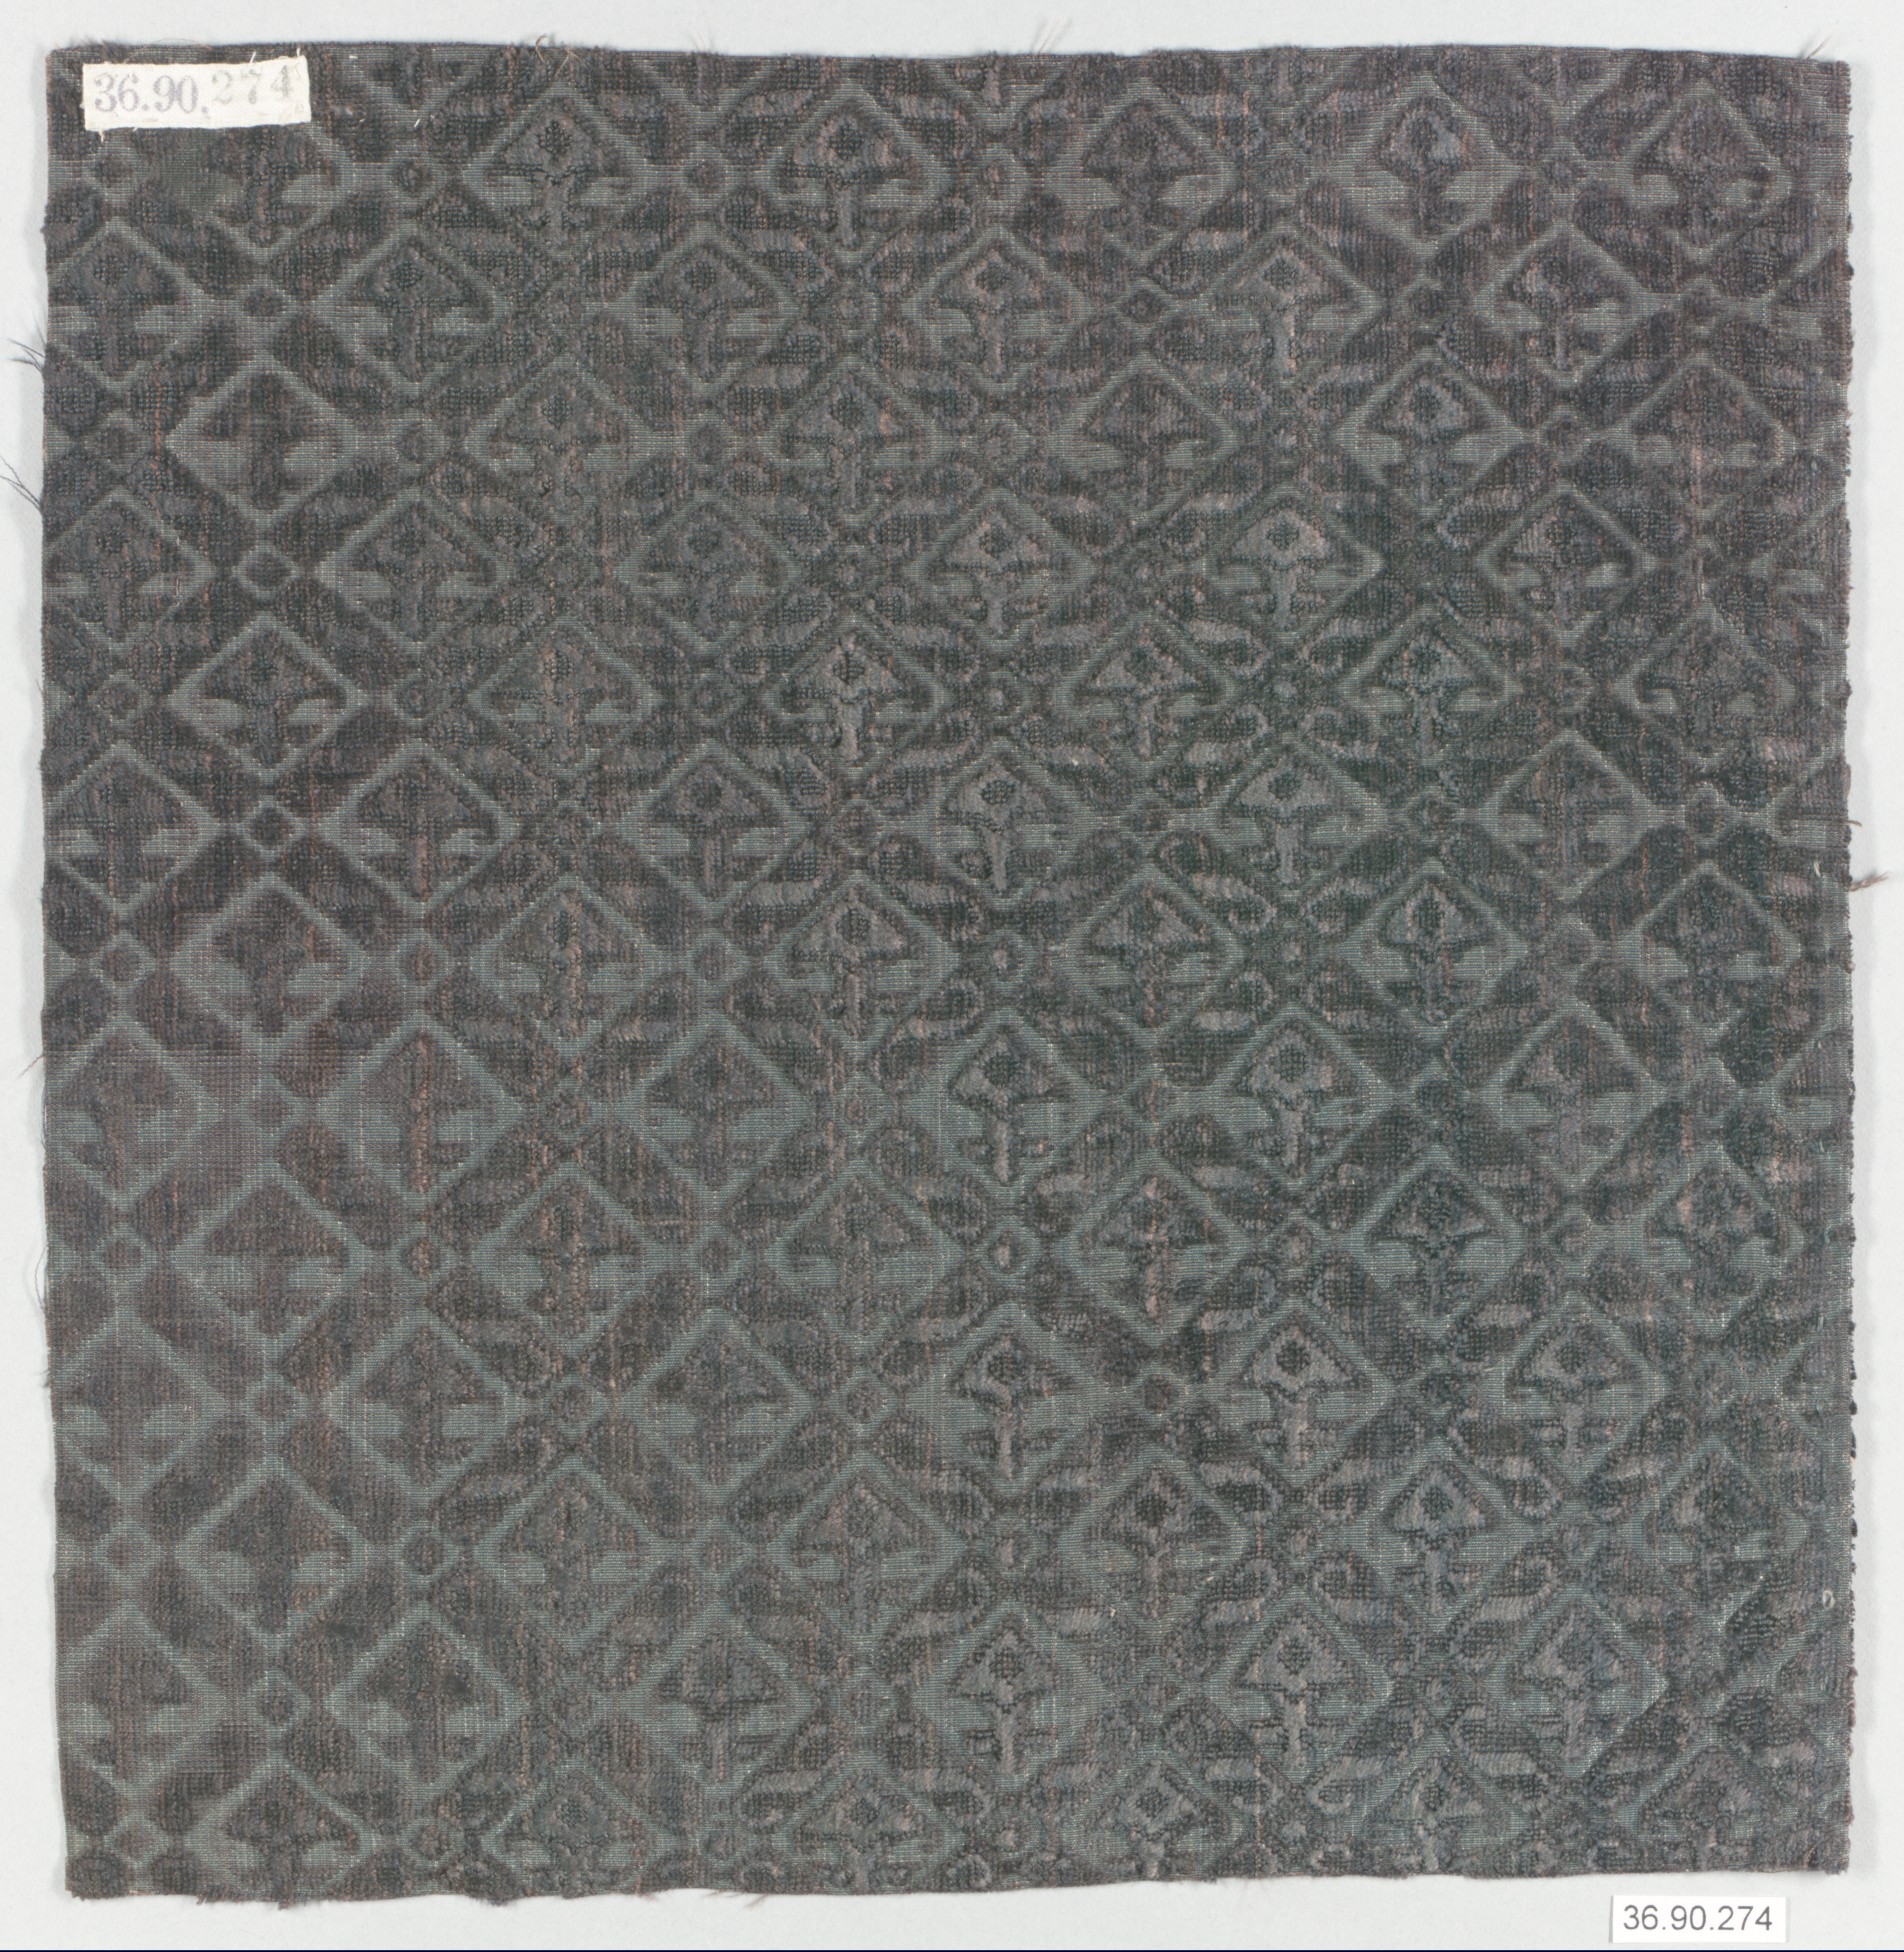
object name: piece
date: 1501-1700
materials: silk